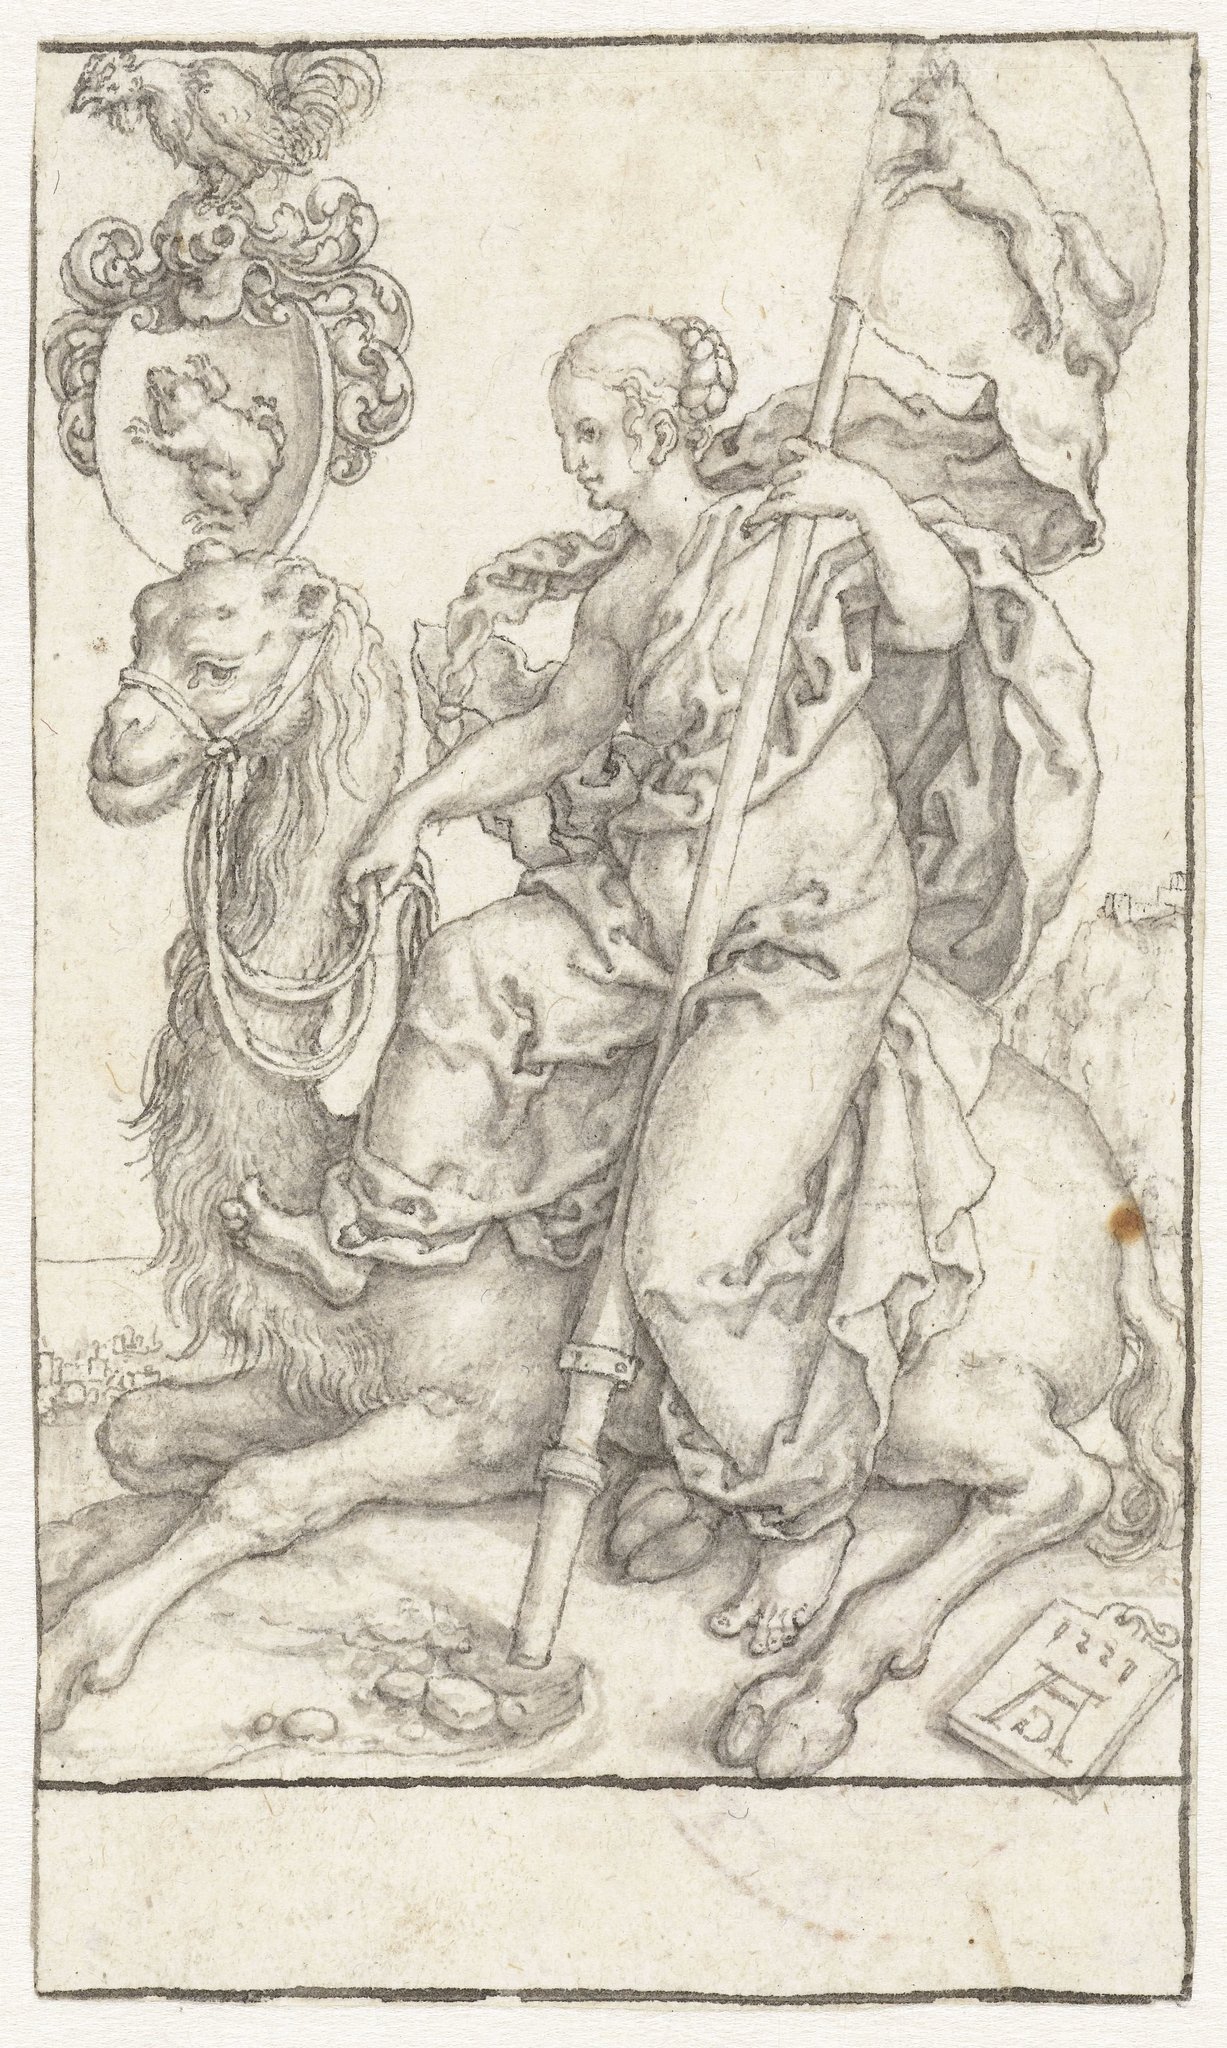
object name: design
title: Ontwerptekeningen voor de prentenserie De Zeven Hoofdzonden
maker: heinrich aldegrever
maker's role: draughtsman, print maker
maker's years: 1502-1561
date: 1551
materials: ink, paper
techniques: brush, pen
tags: lust, luxury, 'luxuria'; 'lussuria' (ripa) ~ personification of one of the deadly sins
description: Compleet: acht ontwerpen aanwezig in RPK.